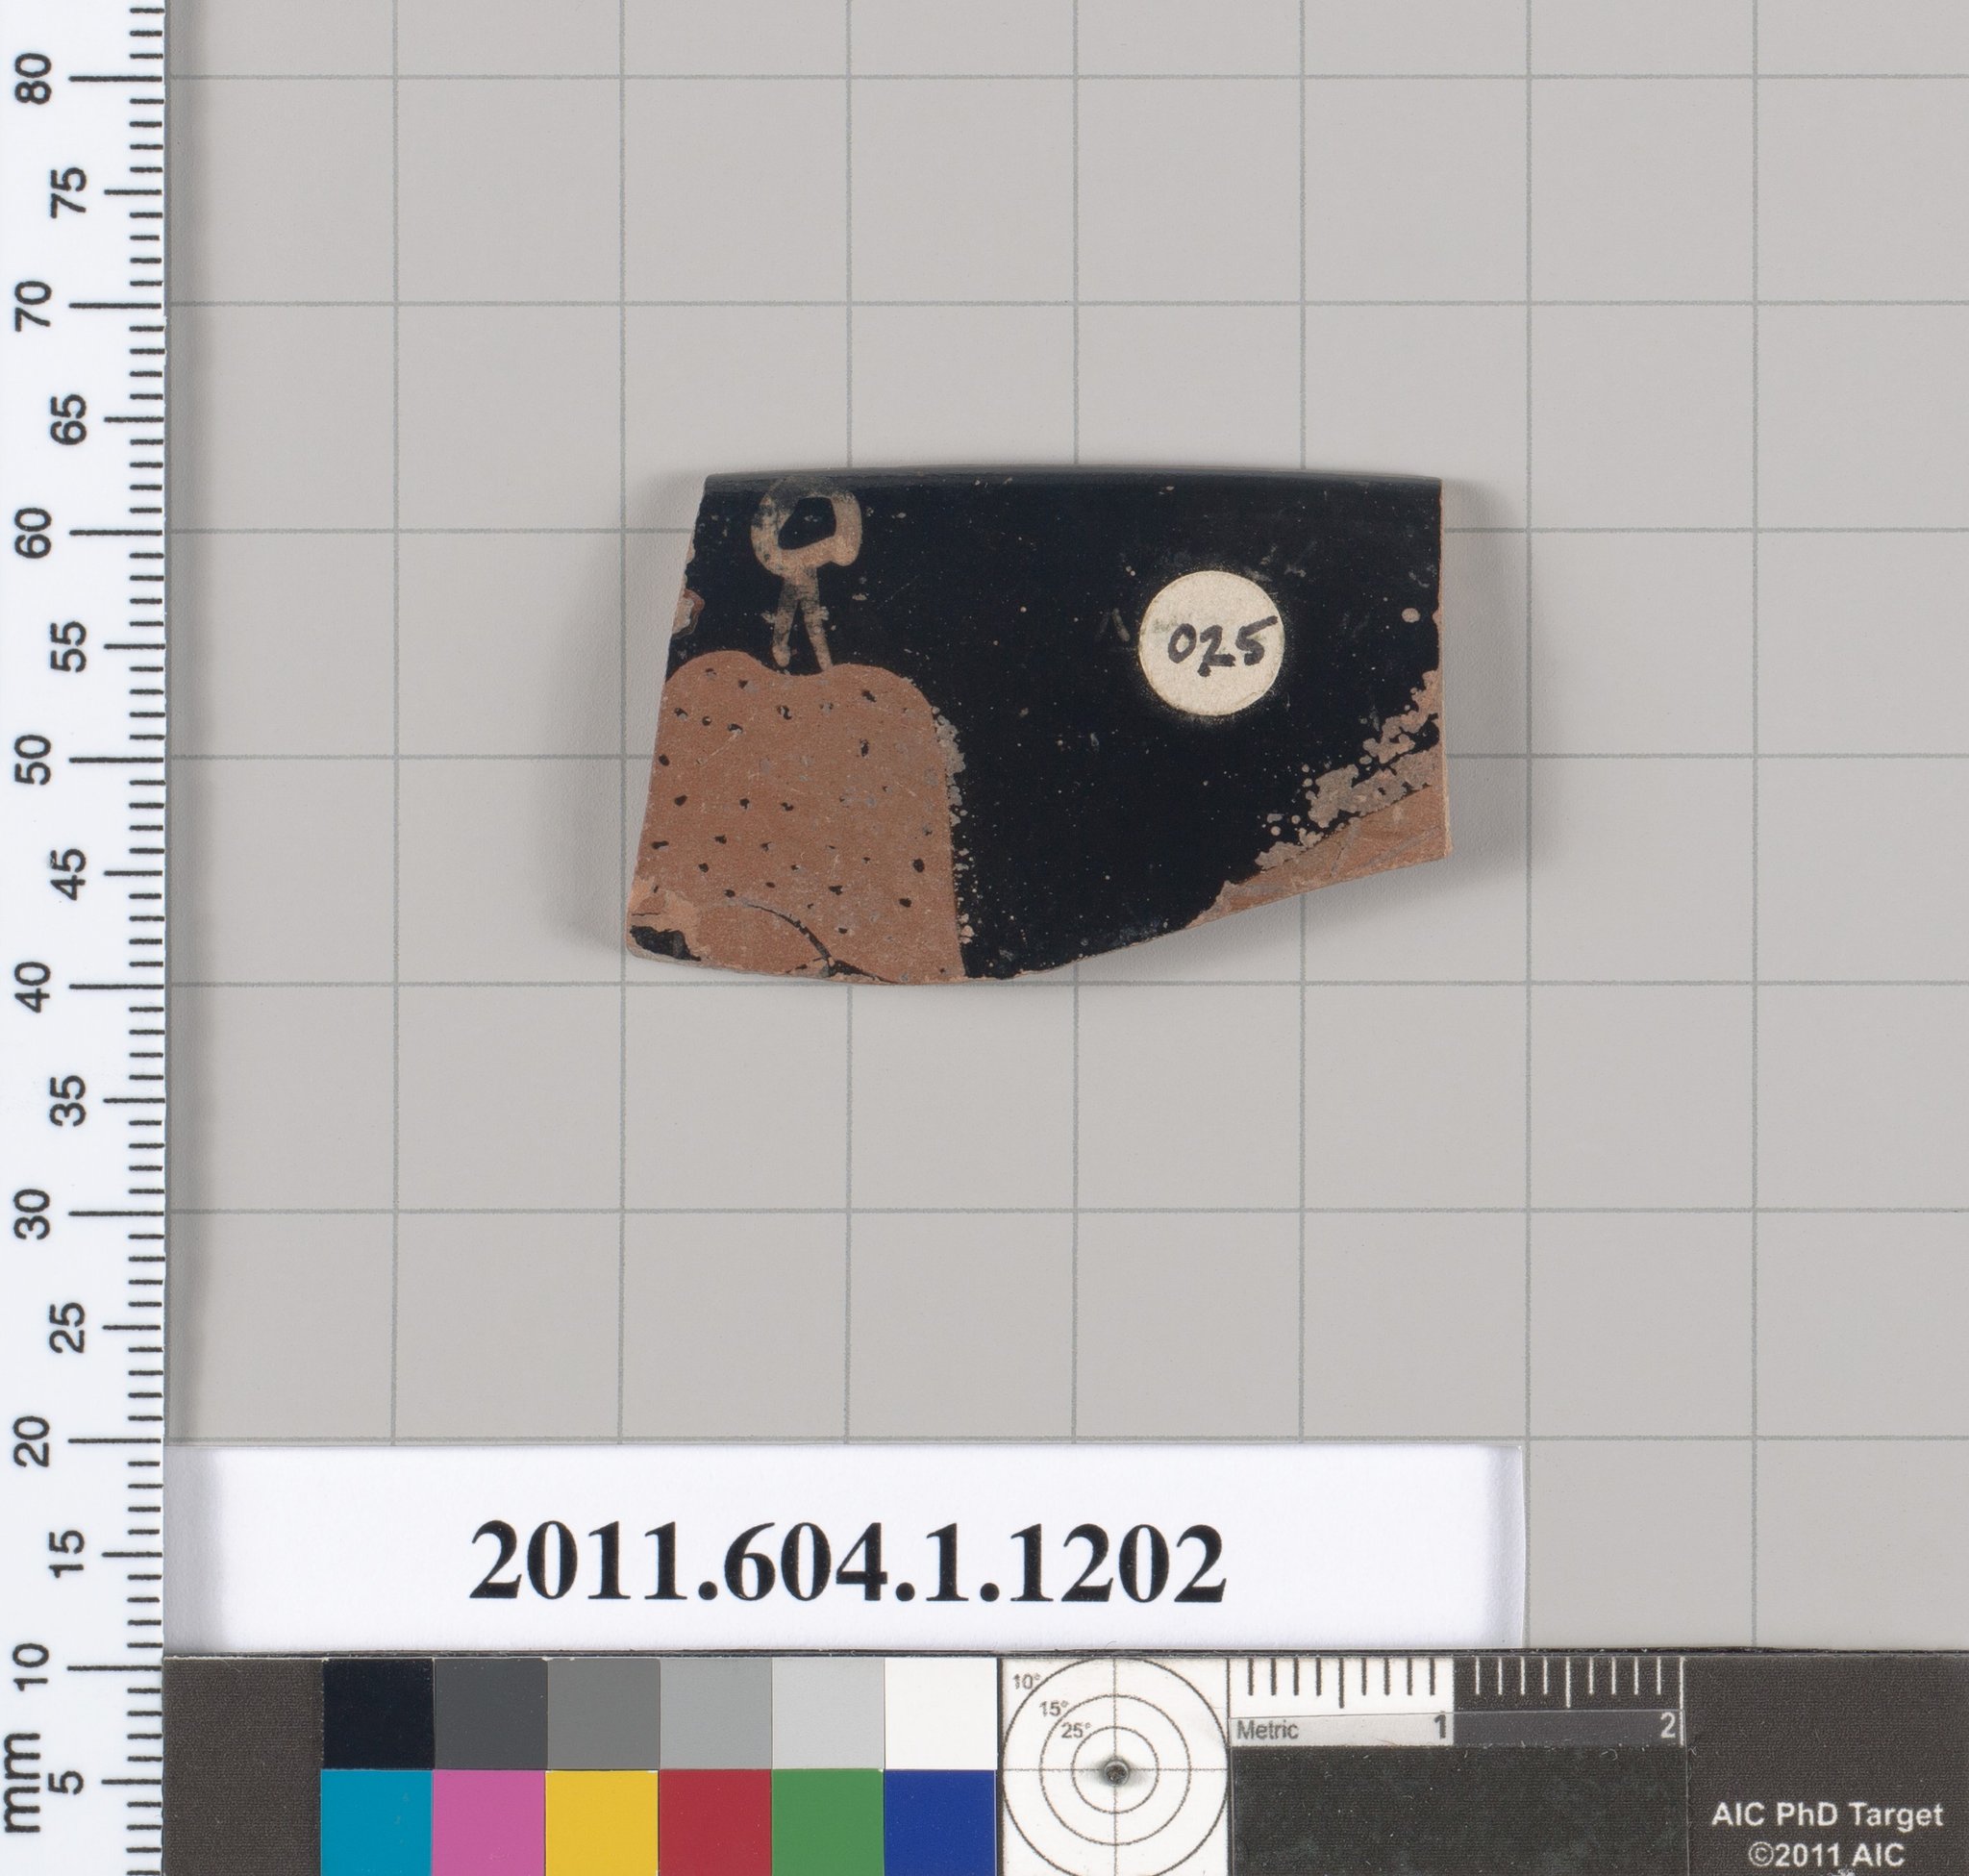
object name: kylix fragment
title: Terracotta rim fragment of a kylix (drinking cup)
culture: greek, attic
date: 490-480 BCE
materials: terracotta